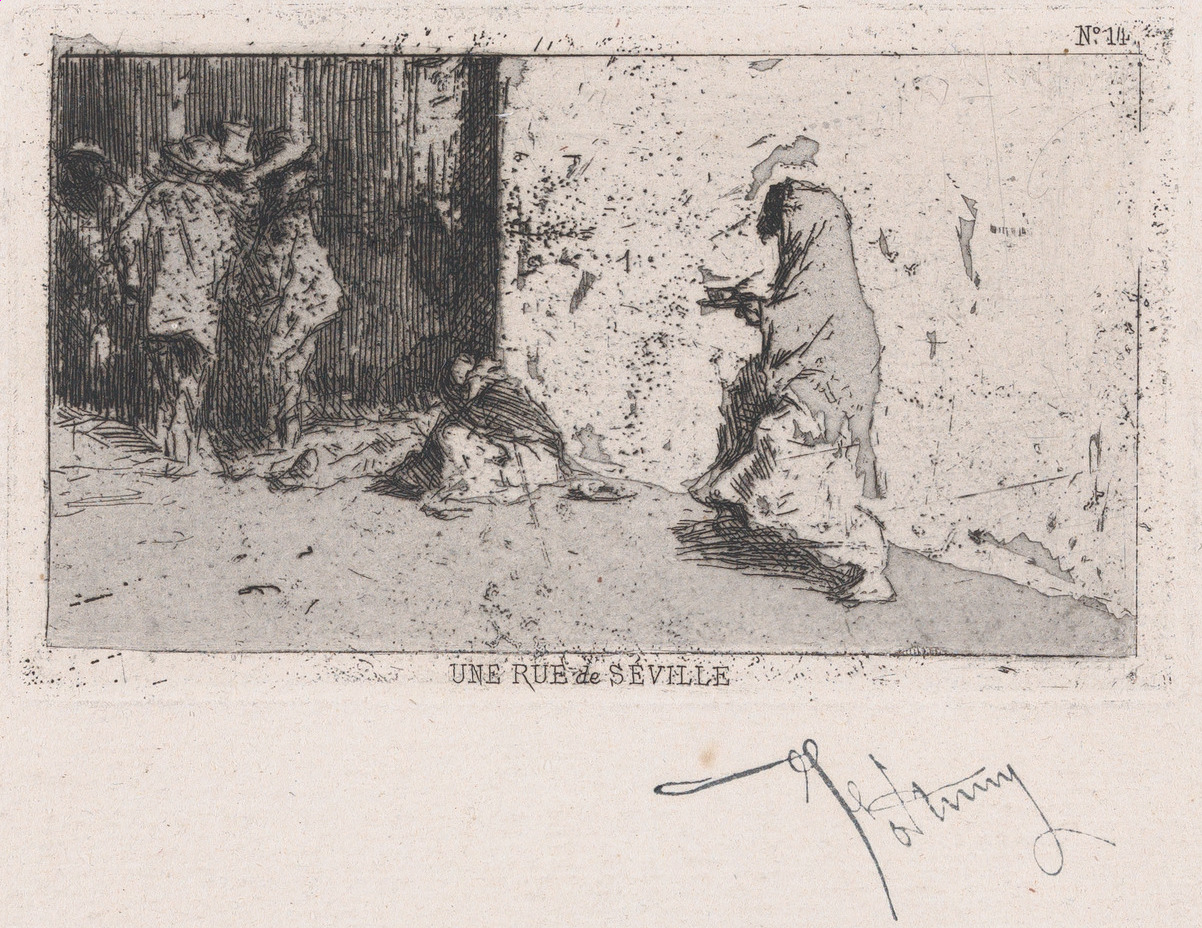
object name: print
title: A street in Seville with figures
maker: mariano fortuny, 1838–1874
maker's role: artist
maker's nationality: spanish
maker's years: 1838-1874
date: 1860-1870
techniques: etching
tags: human figures,streets